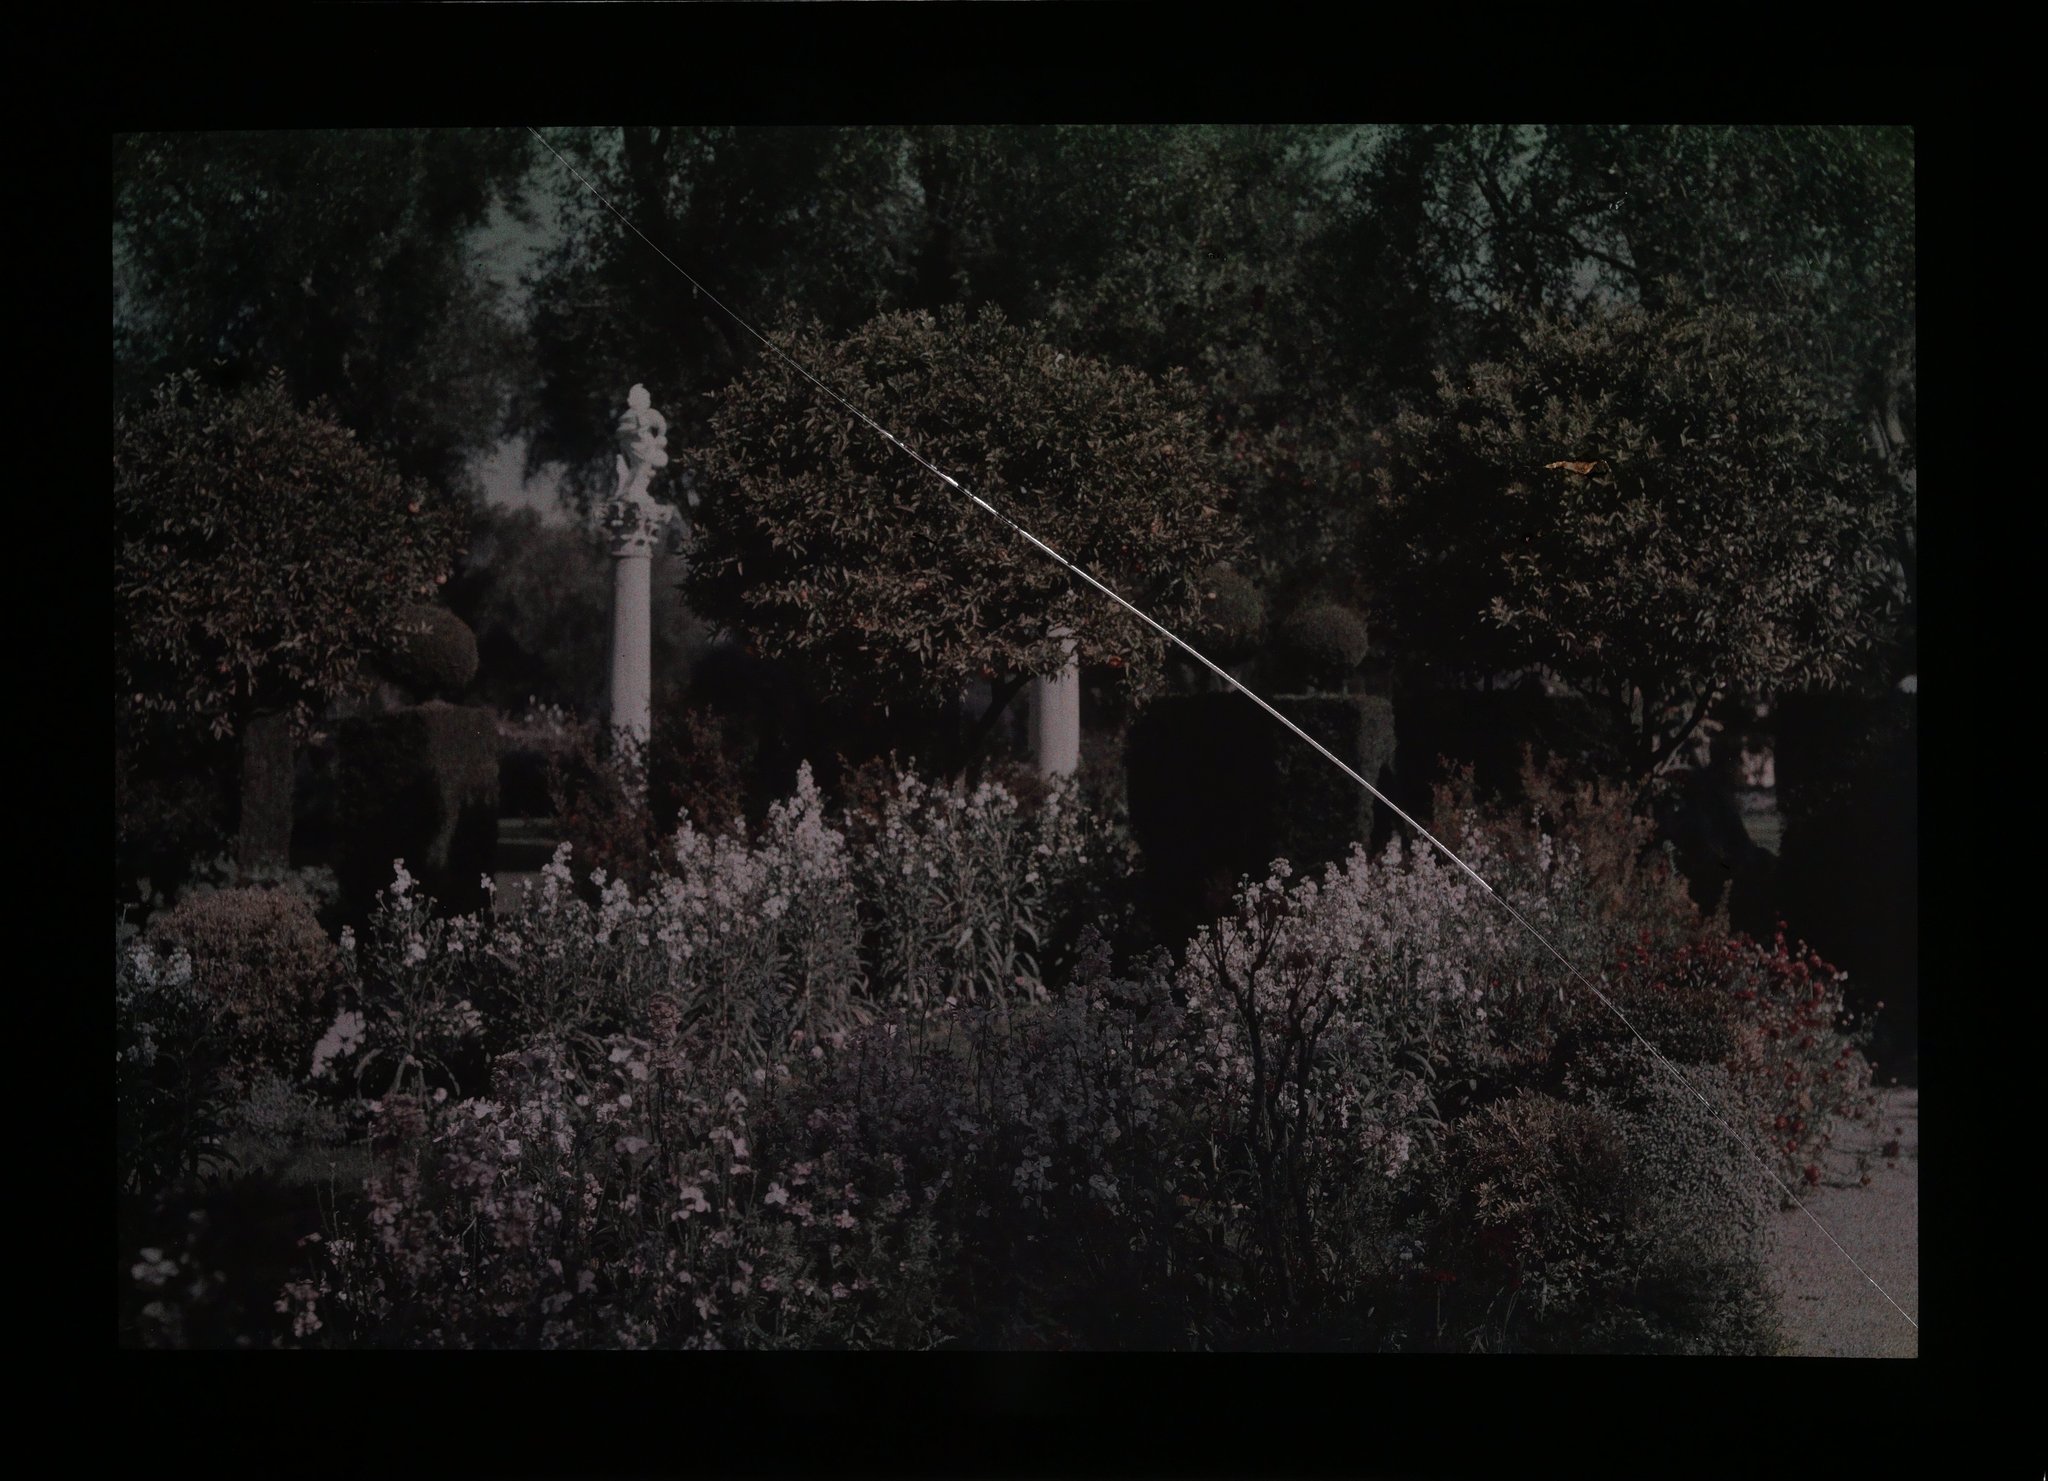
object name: photograph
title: Tuin met bloeiende bomen en planten, en zuilen waarop beelden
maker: Anonymous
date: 1910-1940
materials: glass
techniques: autochrome process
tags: garden